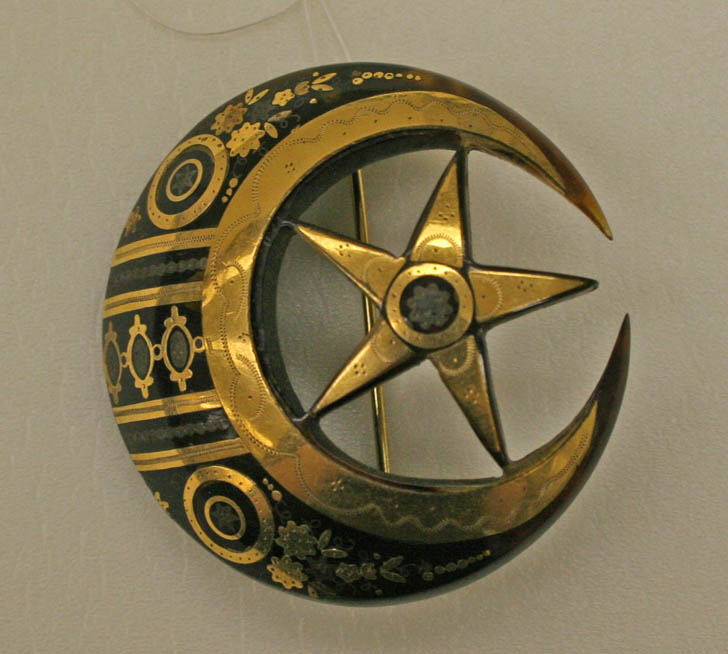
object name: brooch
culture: british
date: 1860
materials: gold, silver, shell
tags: stars